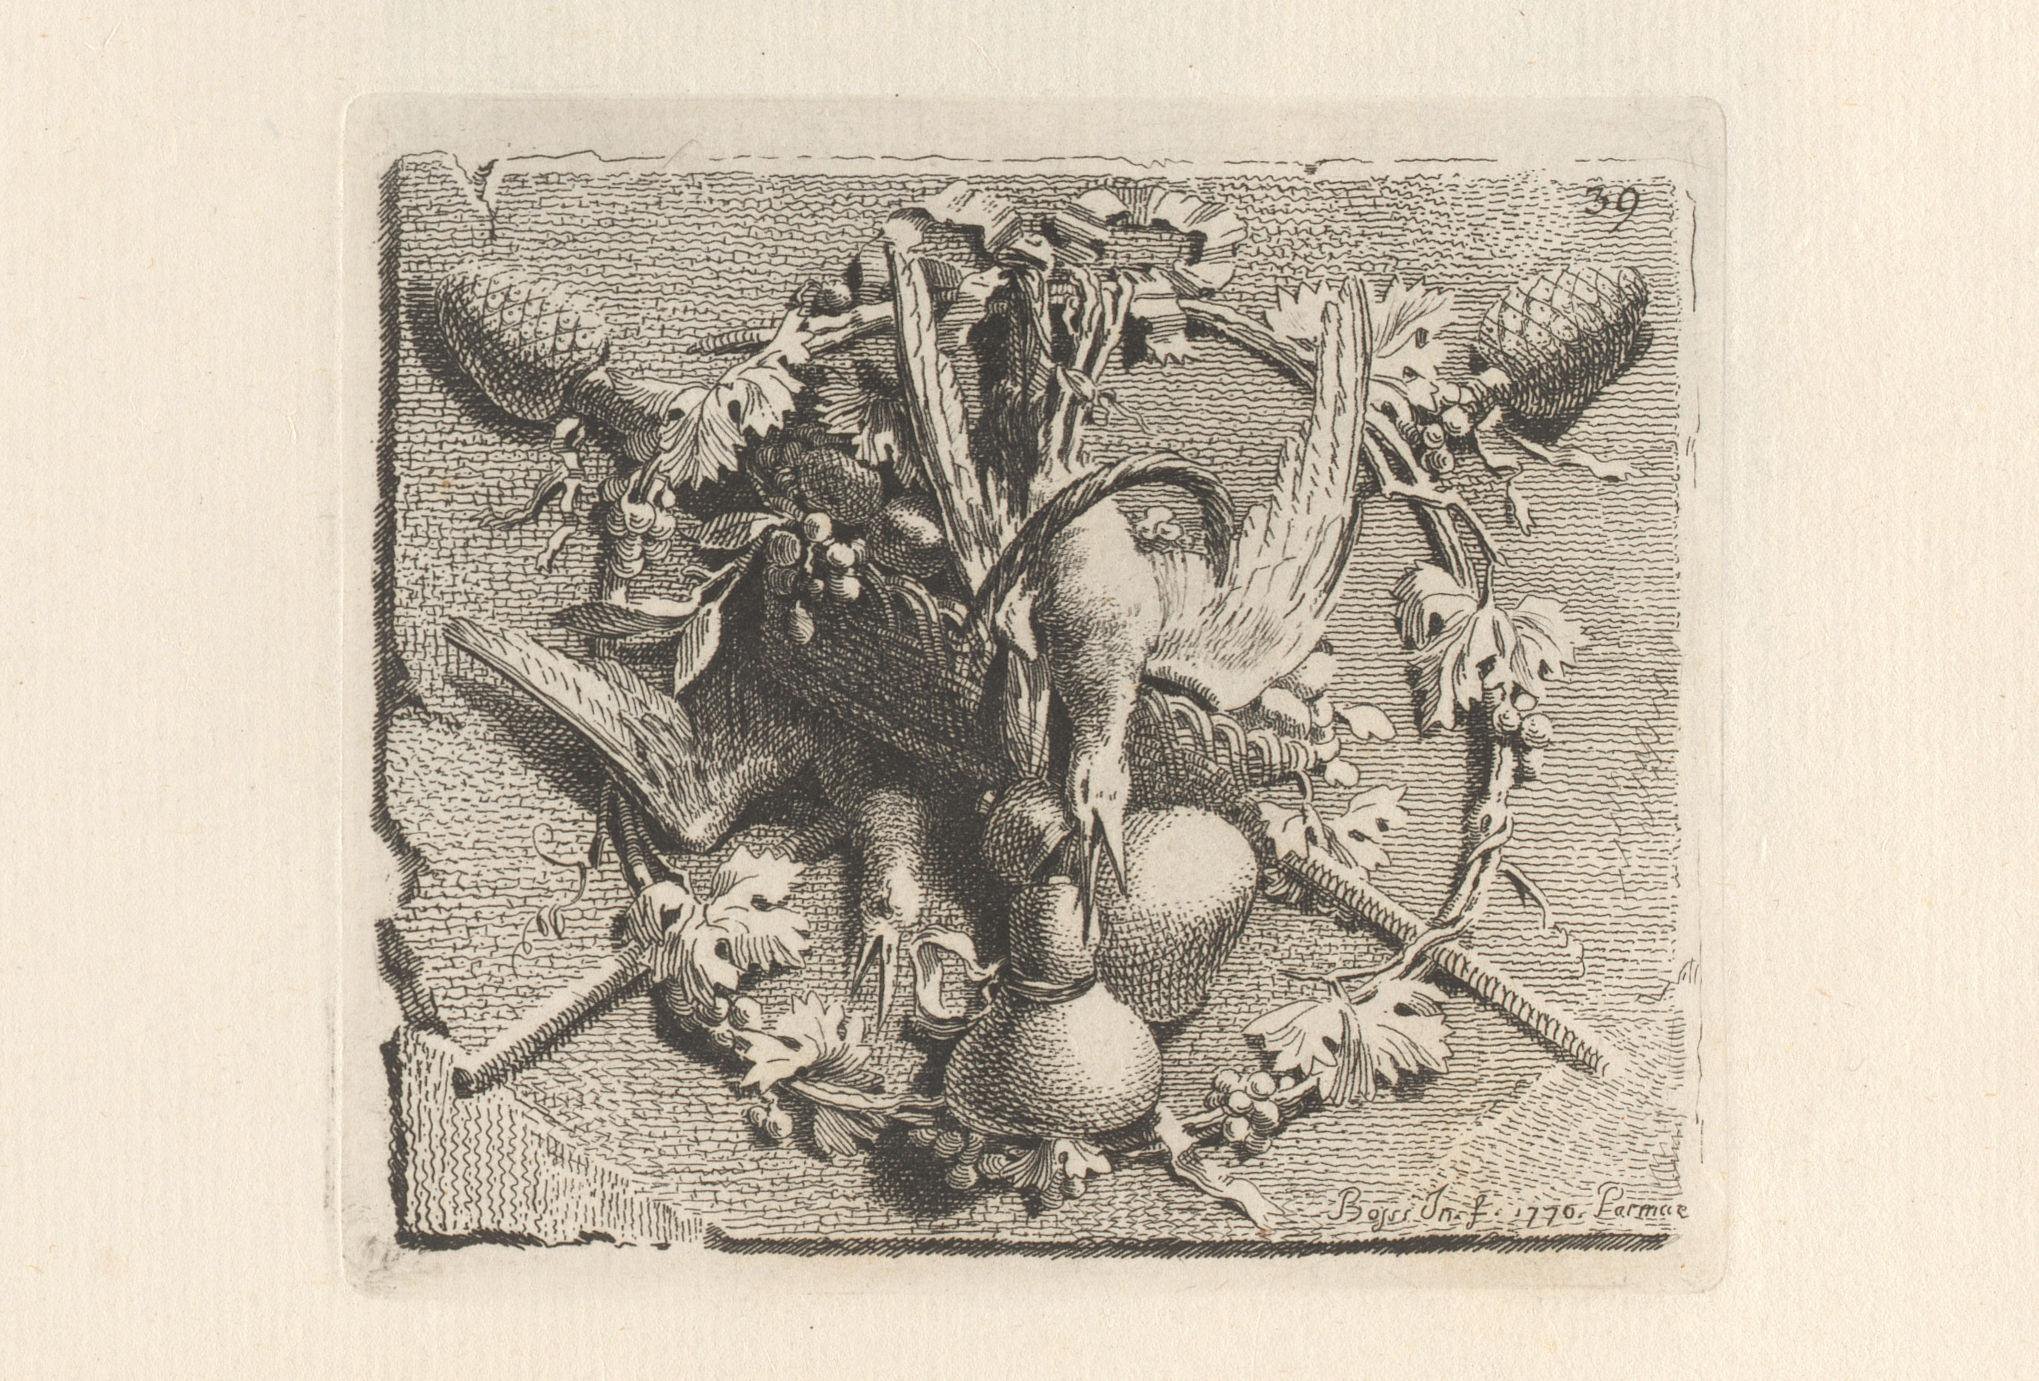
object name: album leaf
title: Raccolta di teste, pensieri, trofei e prove varie d'acquaforte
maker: benigno bossi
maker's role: print maker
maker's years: 1727-1792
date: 1770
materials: paper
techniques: etching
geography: parma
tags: autumn ~ human activities (the four seasons of the year)